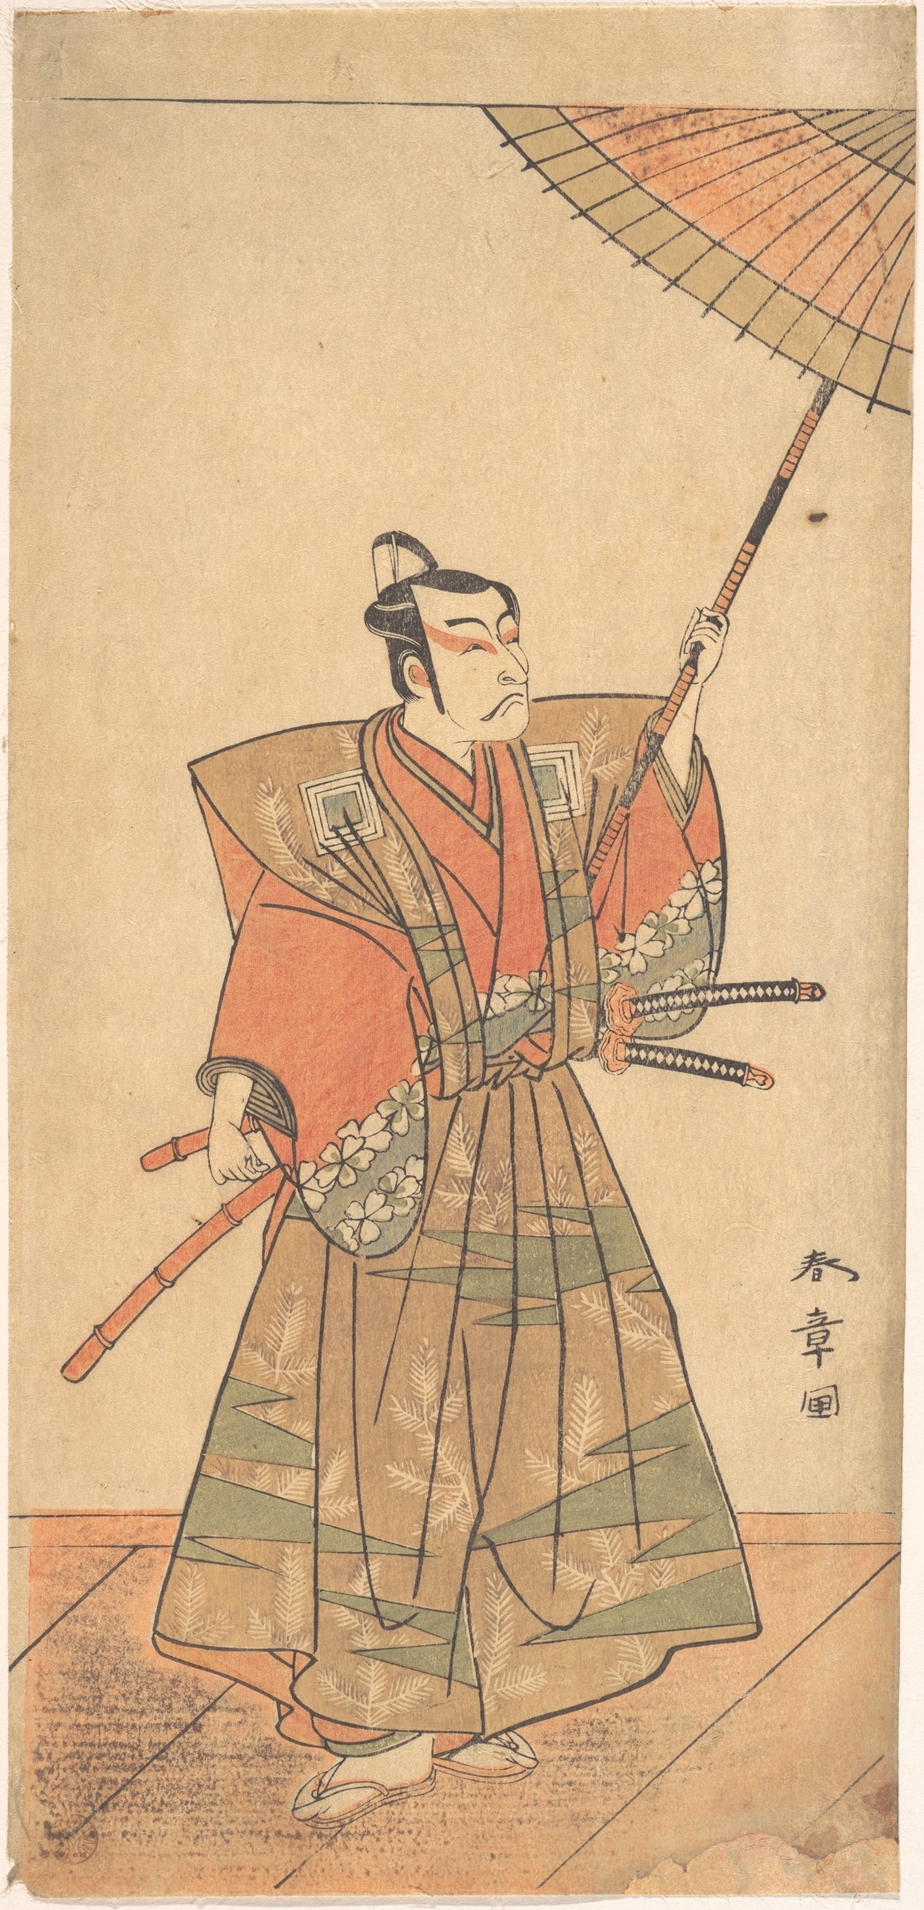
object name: woodblock print nishiki e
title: The Fifth Ichikawa Danjuro as a Samurai Attired in Ceremonial Kamishimo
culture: japanese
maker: katsukawa shunshō 勝川春章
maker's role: artist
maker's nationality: japanese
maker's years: 1726-1792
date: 1774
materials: ink, paper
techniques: nishiki e, woodblock print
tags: samurai,swords,men,actors